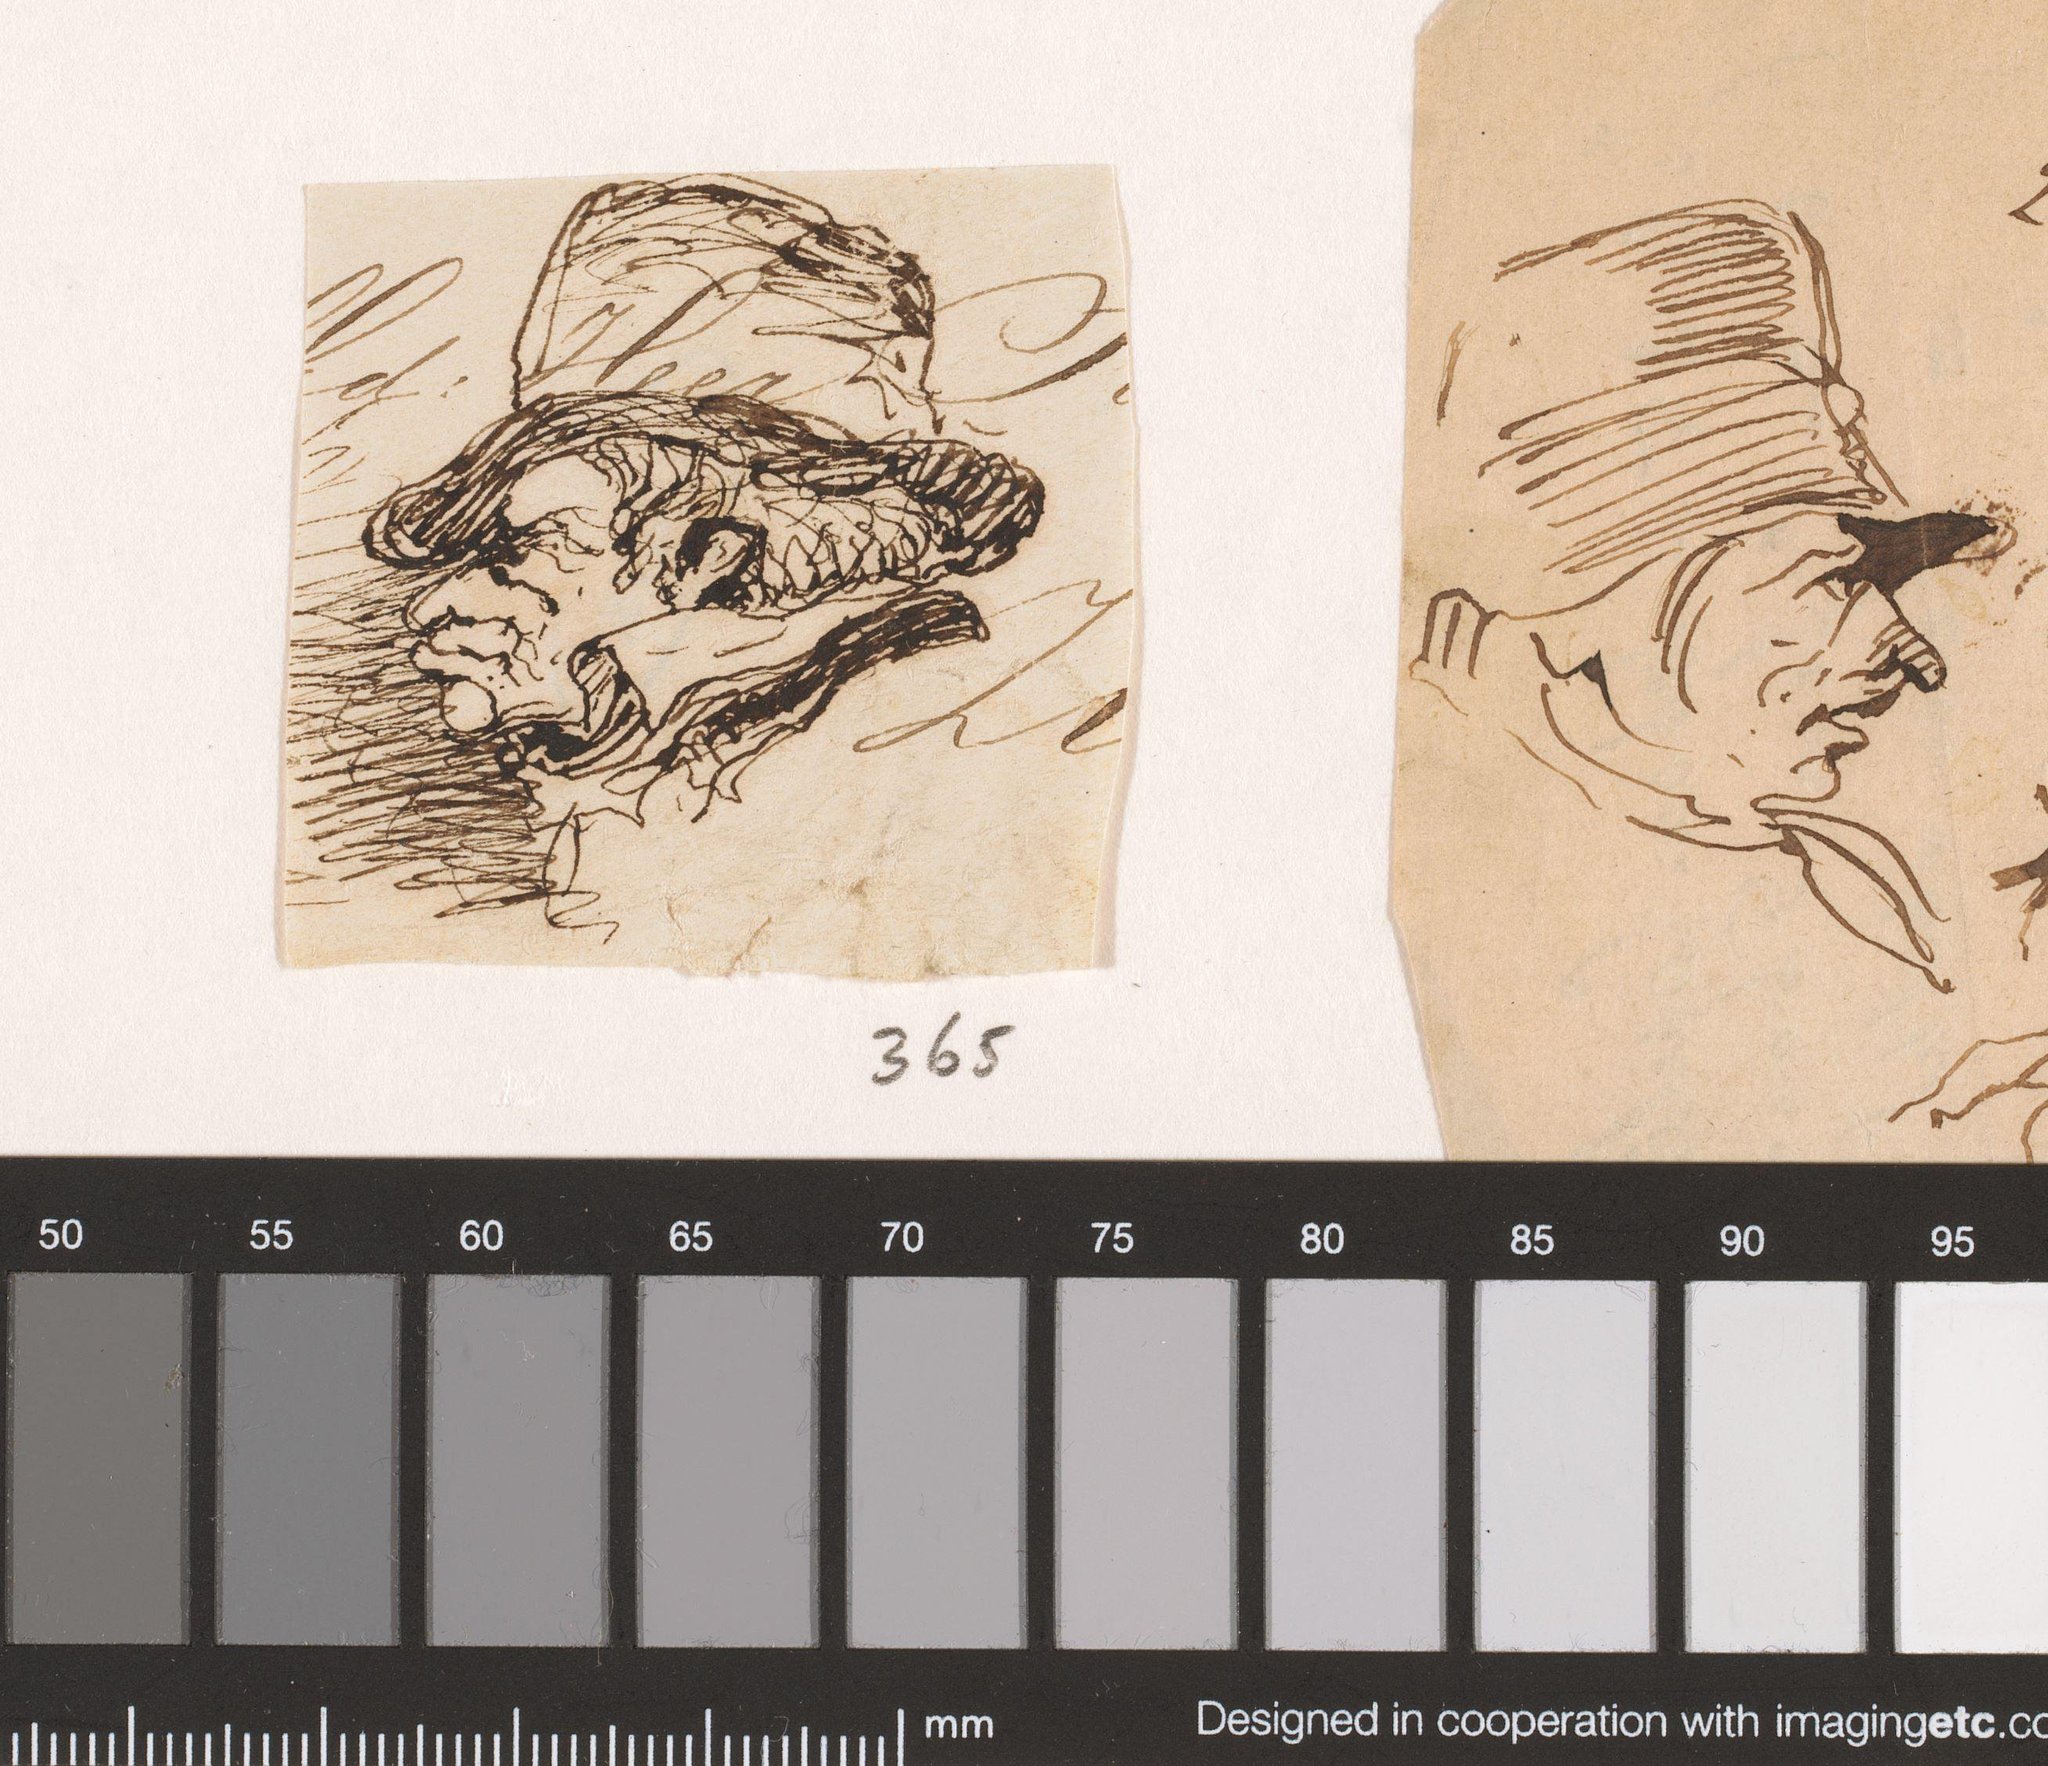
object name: drawing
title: Kop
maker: johannes tavenraat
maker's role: draughtsman, painter, print maker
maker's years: 1809-1881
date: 1840-1880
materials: ink, paper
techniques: pen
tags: caricatures (human types)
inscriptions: collector's mark: Lugt 2228